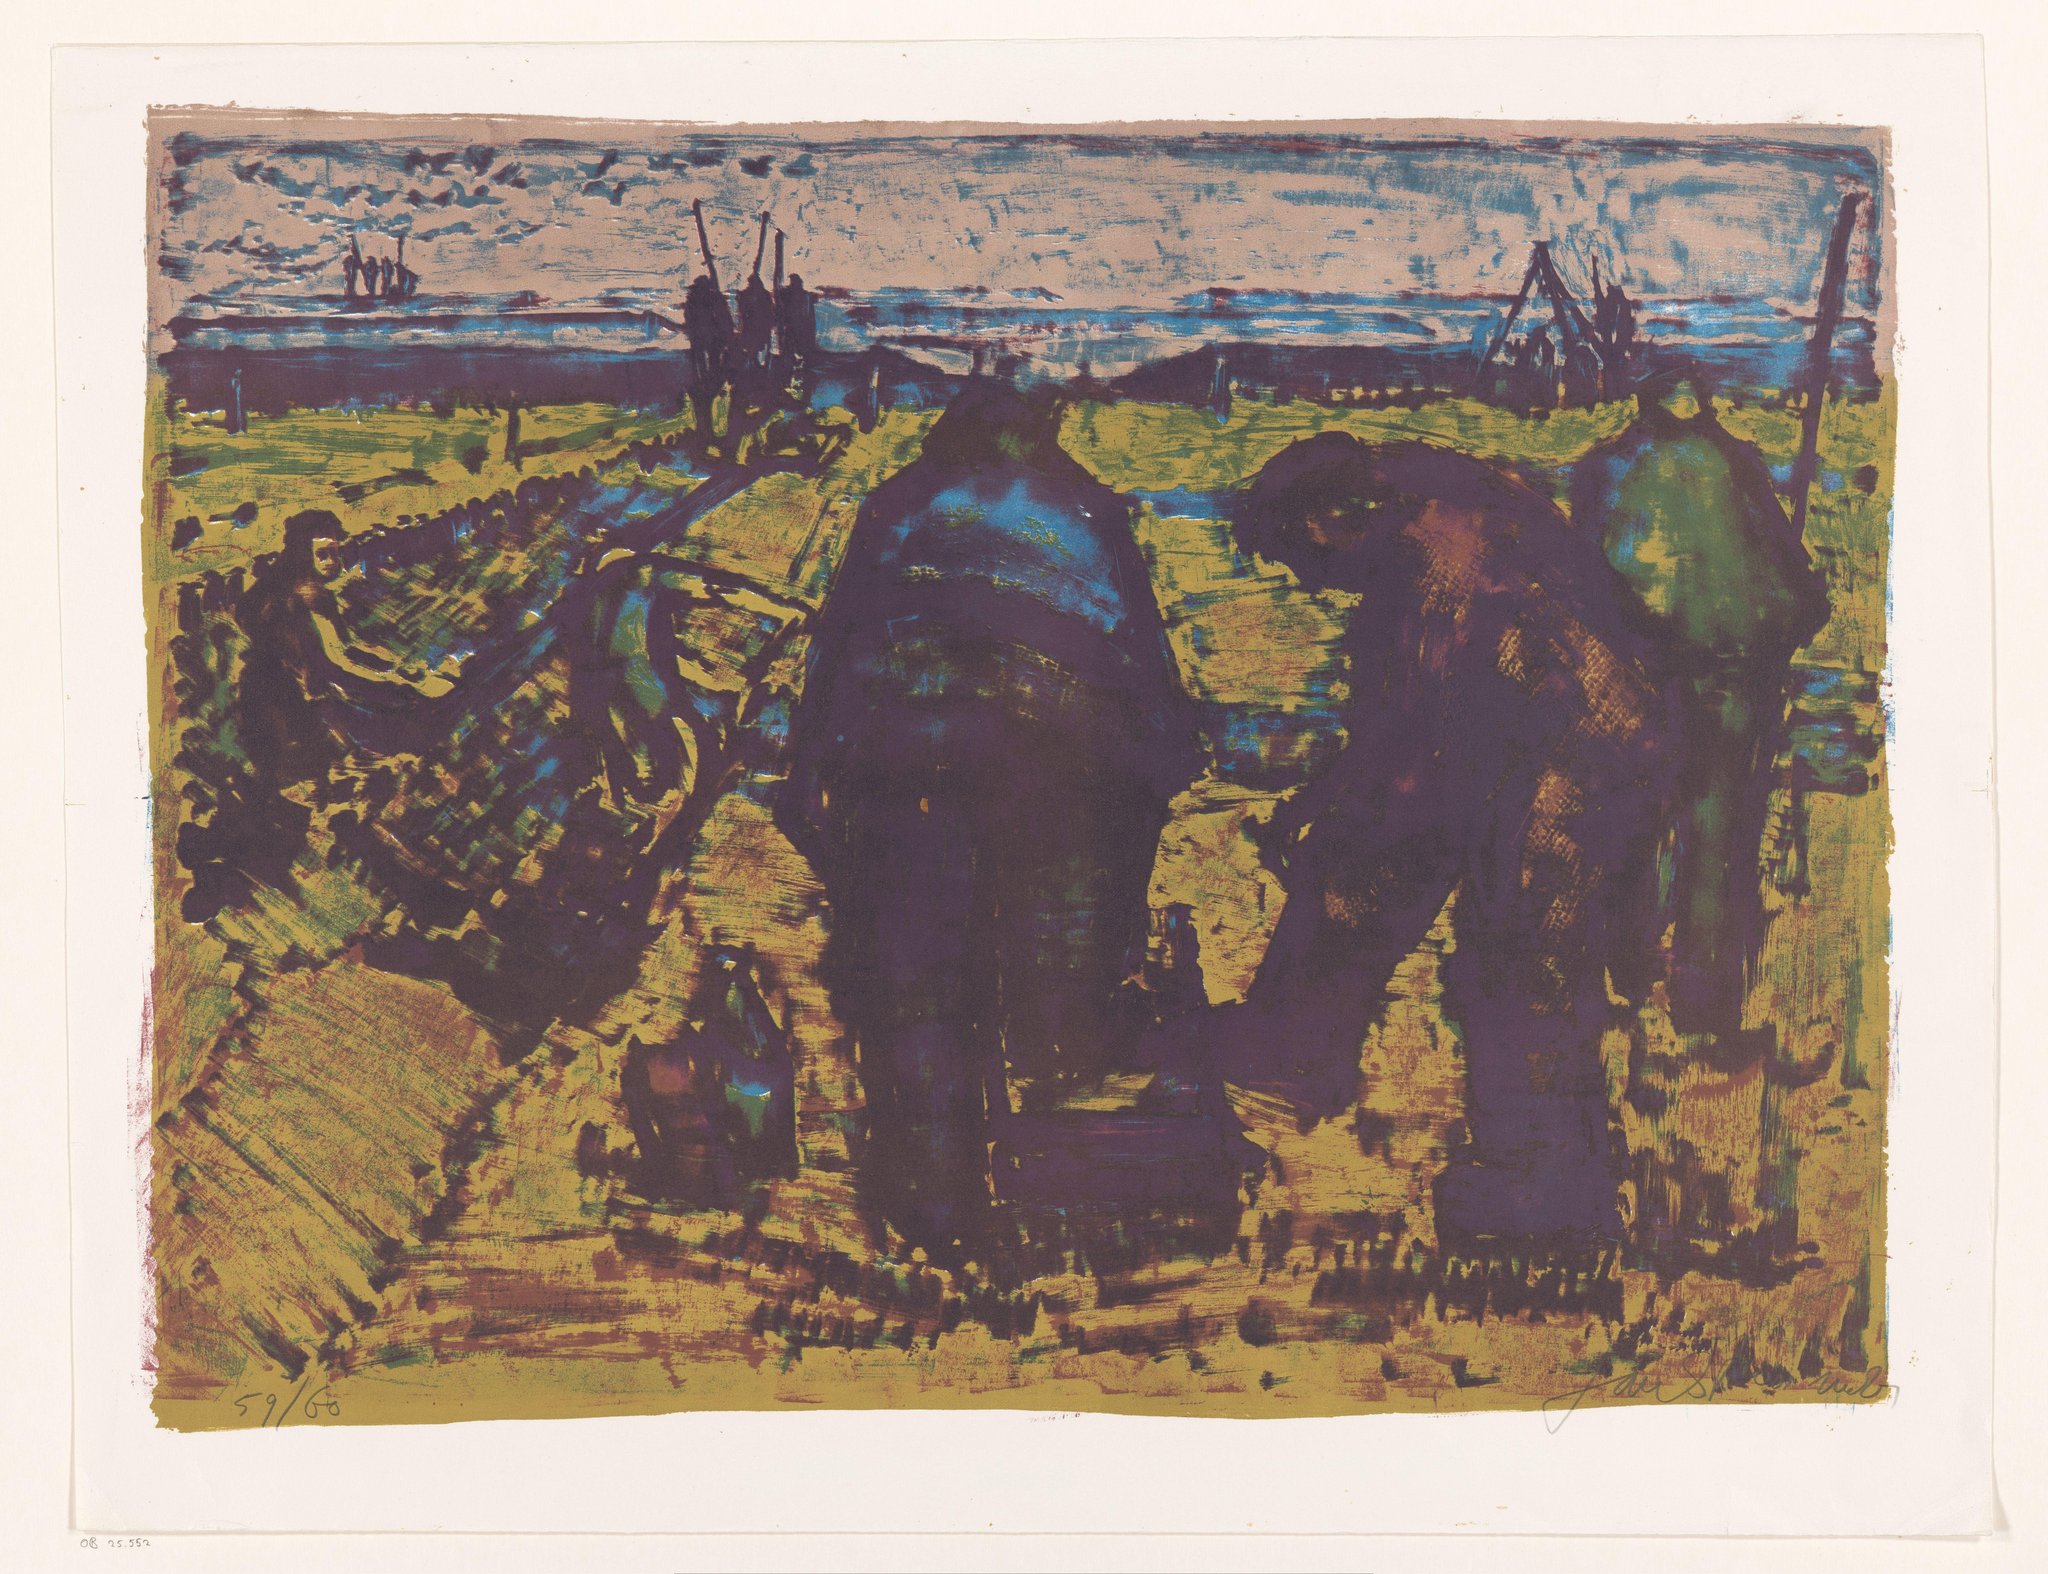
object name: print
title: Dijkwerkers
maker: Anonymous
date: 1960-1990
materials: paper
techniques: lithograph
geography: netherlands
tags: dikes, levee, labour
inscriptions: collector's mark: Lugt 2228